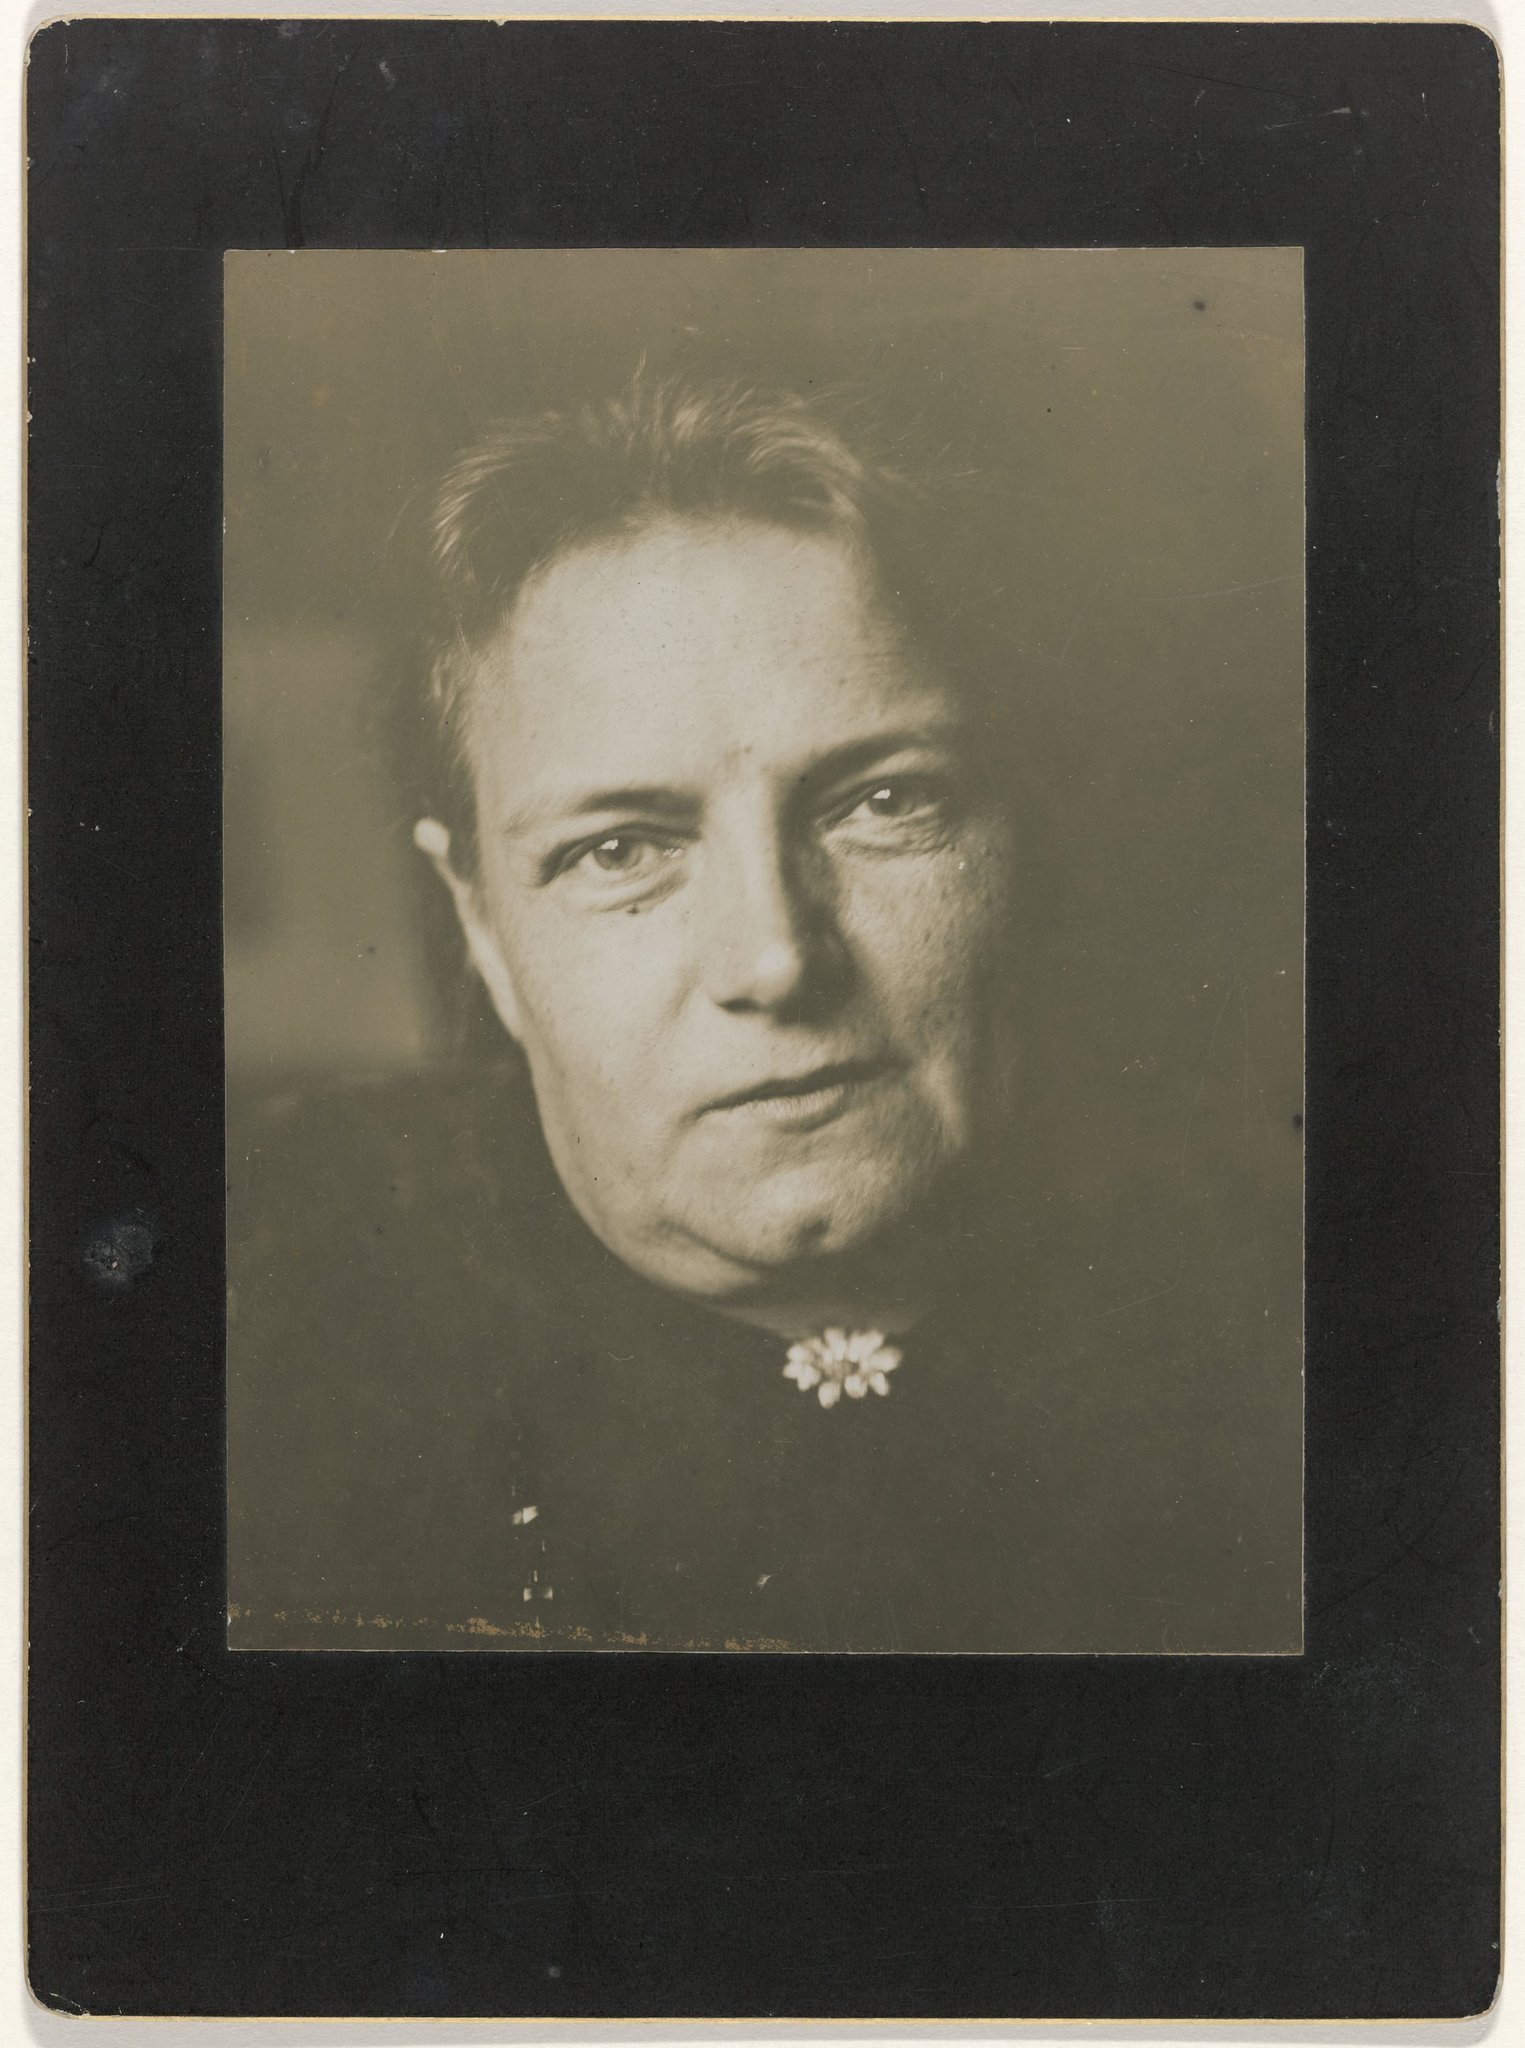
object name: photograph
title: Portret van een onbekende vrouw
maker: willem witsen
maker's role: draughtsman, painter, print maker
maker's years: 1860-1923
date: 1890-1900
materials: cardboard, paper, photographic support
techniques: gelatin silver print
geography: amsterdam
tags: historical persons not known by name - bb - woman, netherlands